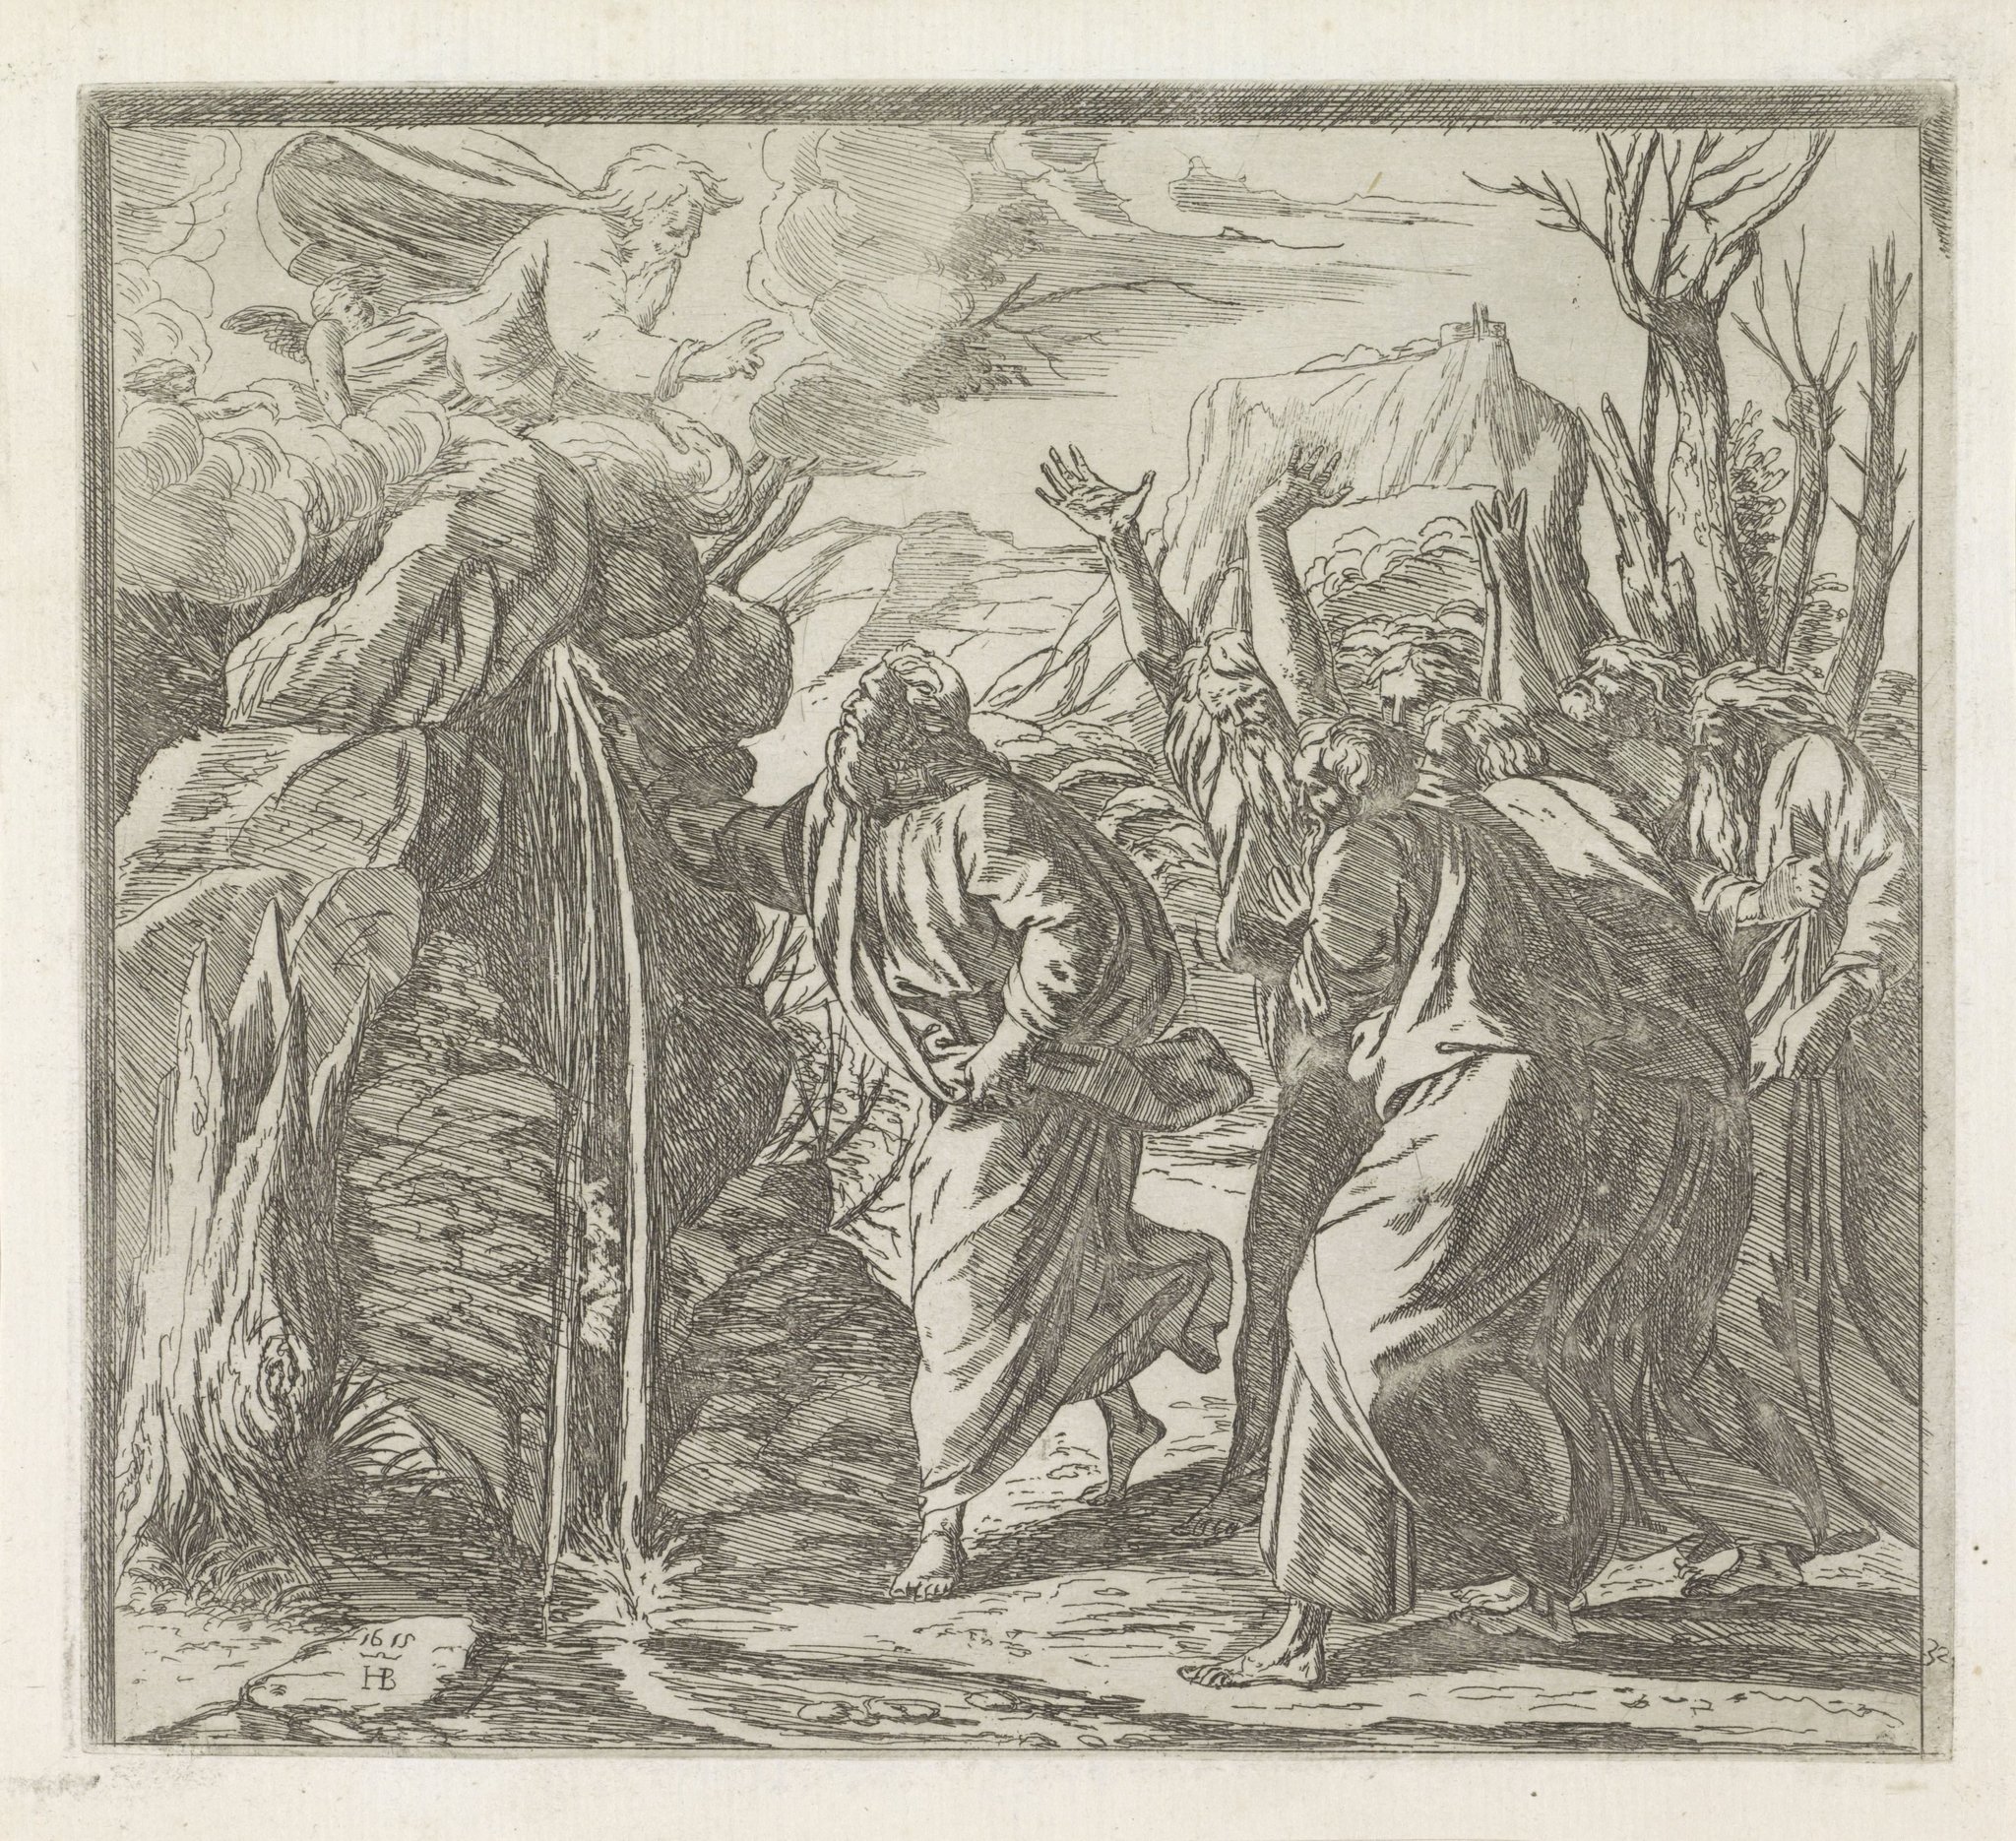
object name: print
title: Schilderingen in de Loggia van Rafaël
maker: orazio borgianni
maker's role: print maker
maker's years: 1578-1616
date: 1615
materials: paper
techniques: etching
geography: vatican city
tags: moses striking water from the rock (exodus 17:1-7; numbers 20:2-13)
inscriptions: collector's mark: Lugt 2165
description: Prent uit een reeks van 52 prenten naar schilderingen in de Loggia van Rafaël in het Vaticaan.